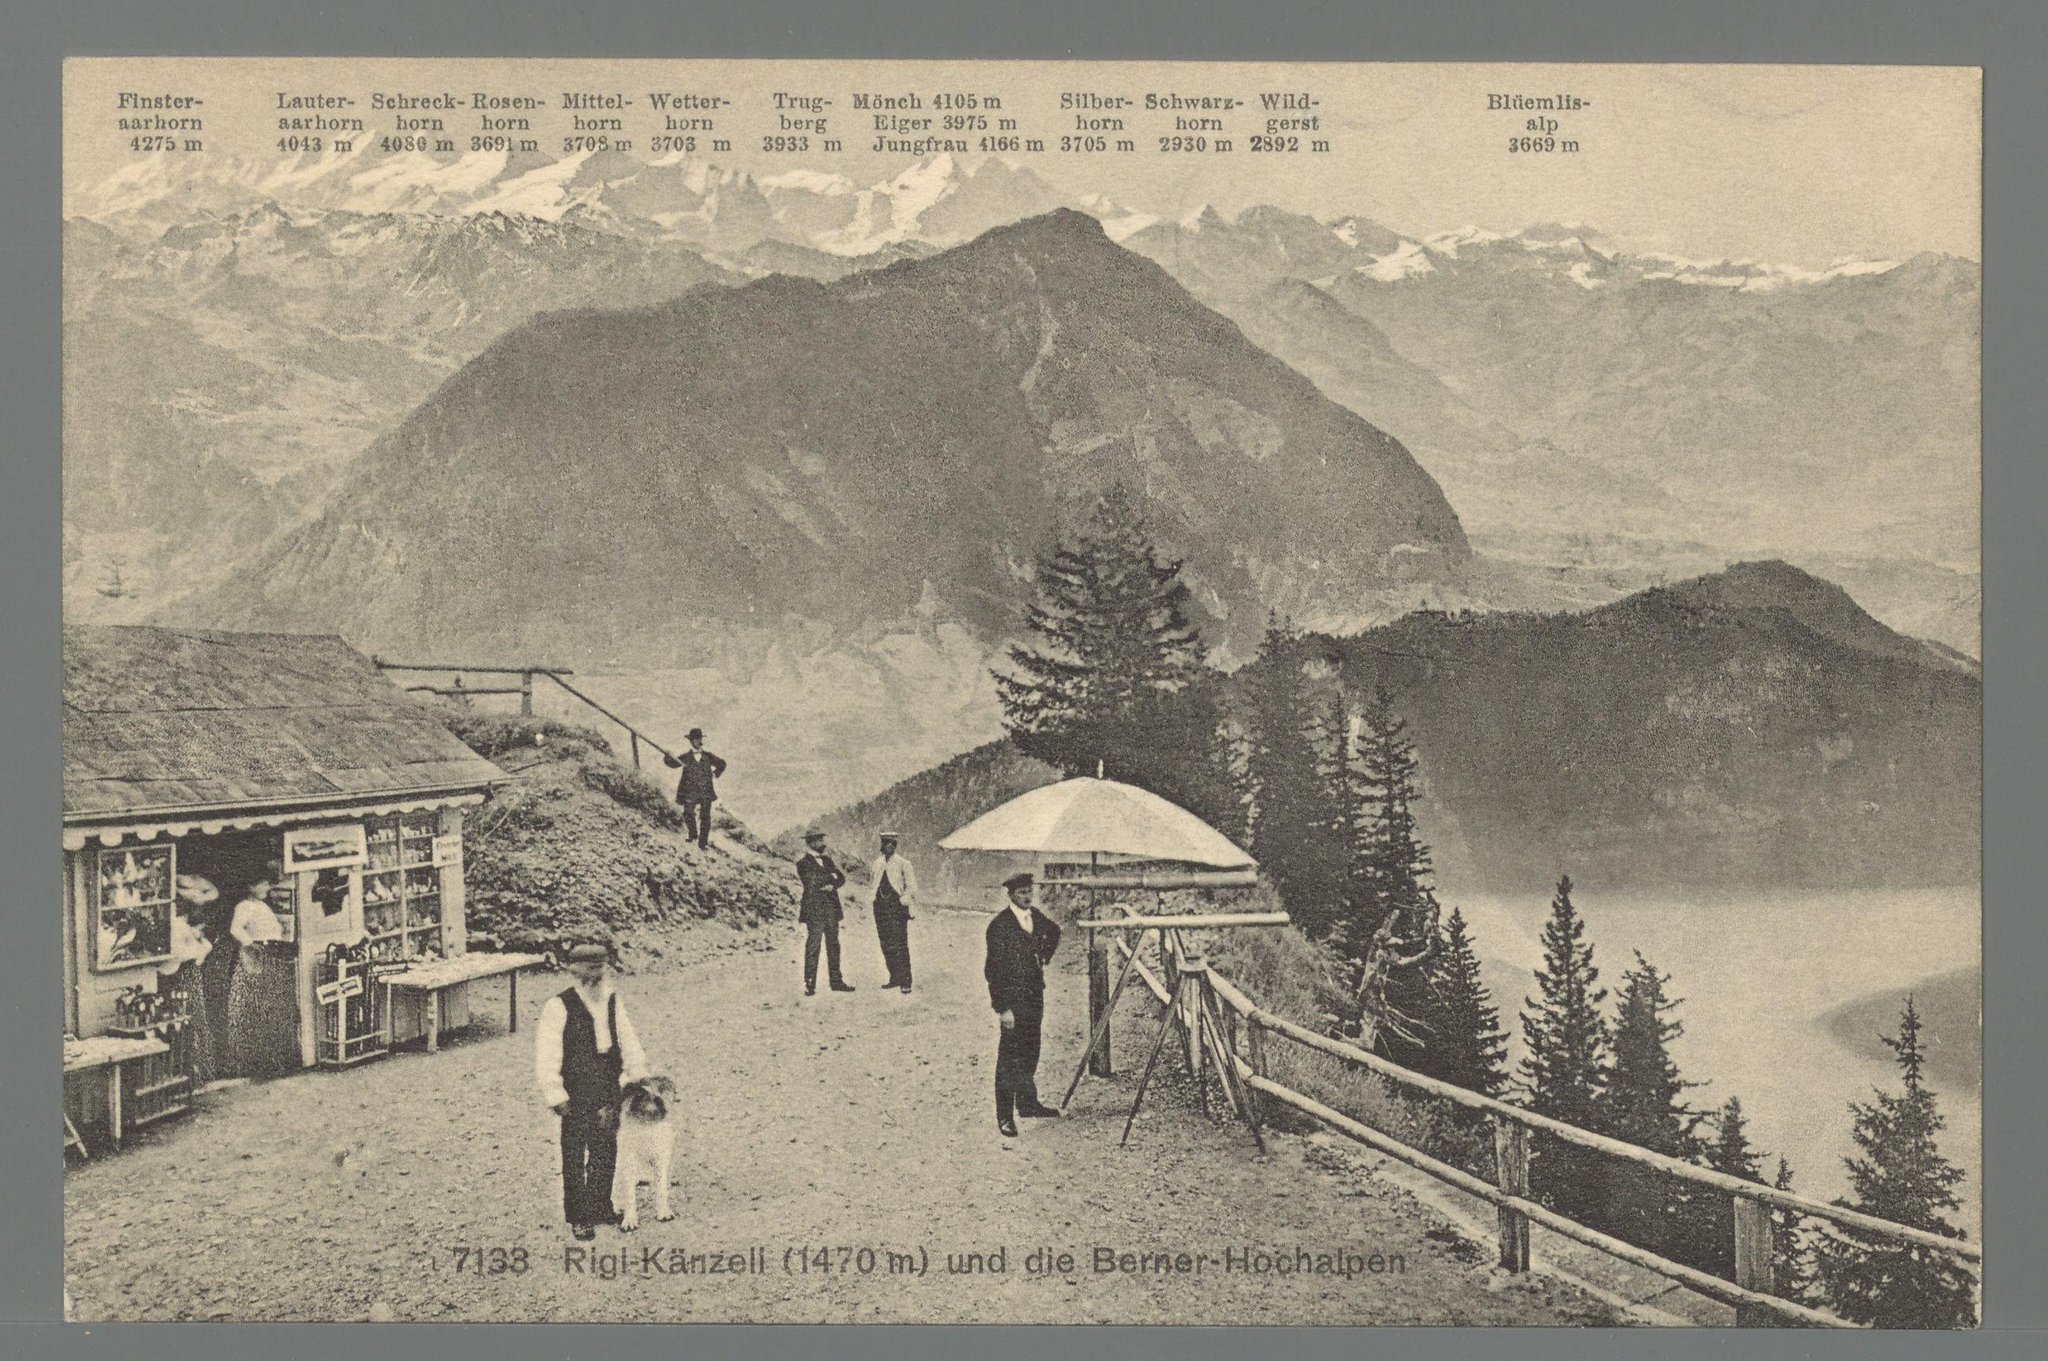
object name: photomechanical print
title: Rigi -Känzeli (1470 m) und die Berner-Hochalpen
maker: Anonymous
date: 1905-1920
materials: cardboard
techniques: photograph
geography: zurich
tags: mountain-range, snow peaks (+ landscape with figures, staffage), open-air recreation